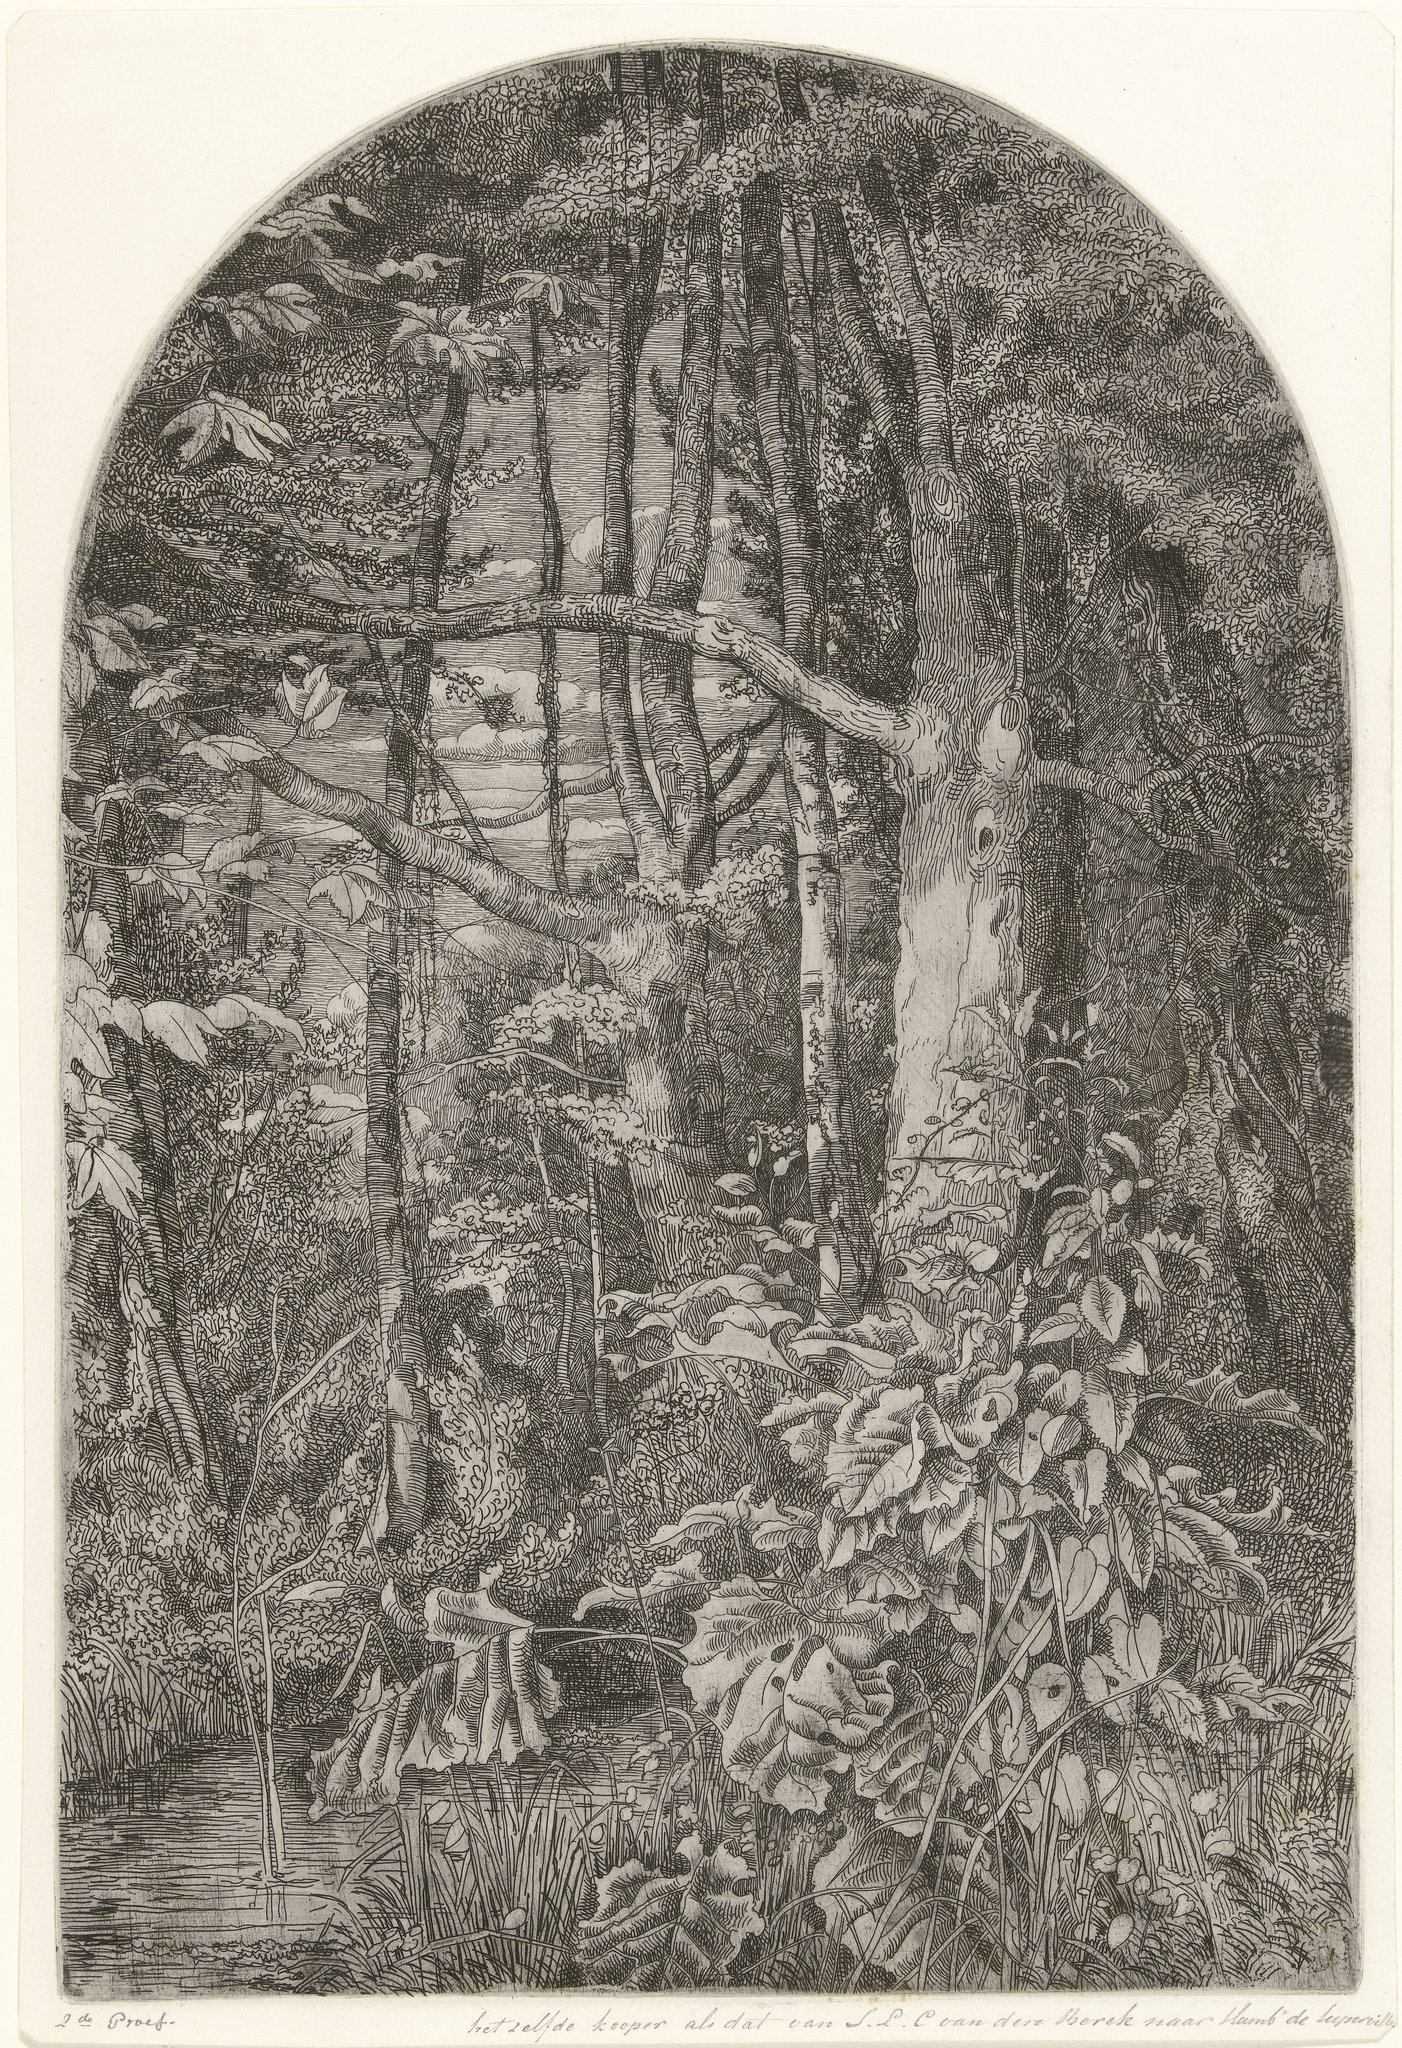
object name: print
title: Bos met beek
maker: jacobus ludovicus cornet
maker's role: draughtsman, print maker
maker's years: 1815-1882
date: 1825-1882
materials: paper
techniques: etching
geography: leiden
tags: brook, deciduous forest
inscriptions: collector's mark: Lugt 2166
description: Een dichtbegroeid woud. Een klein beekje stroomt van links naar rechts.